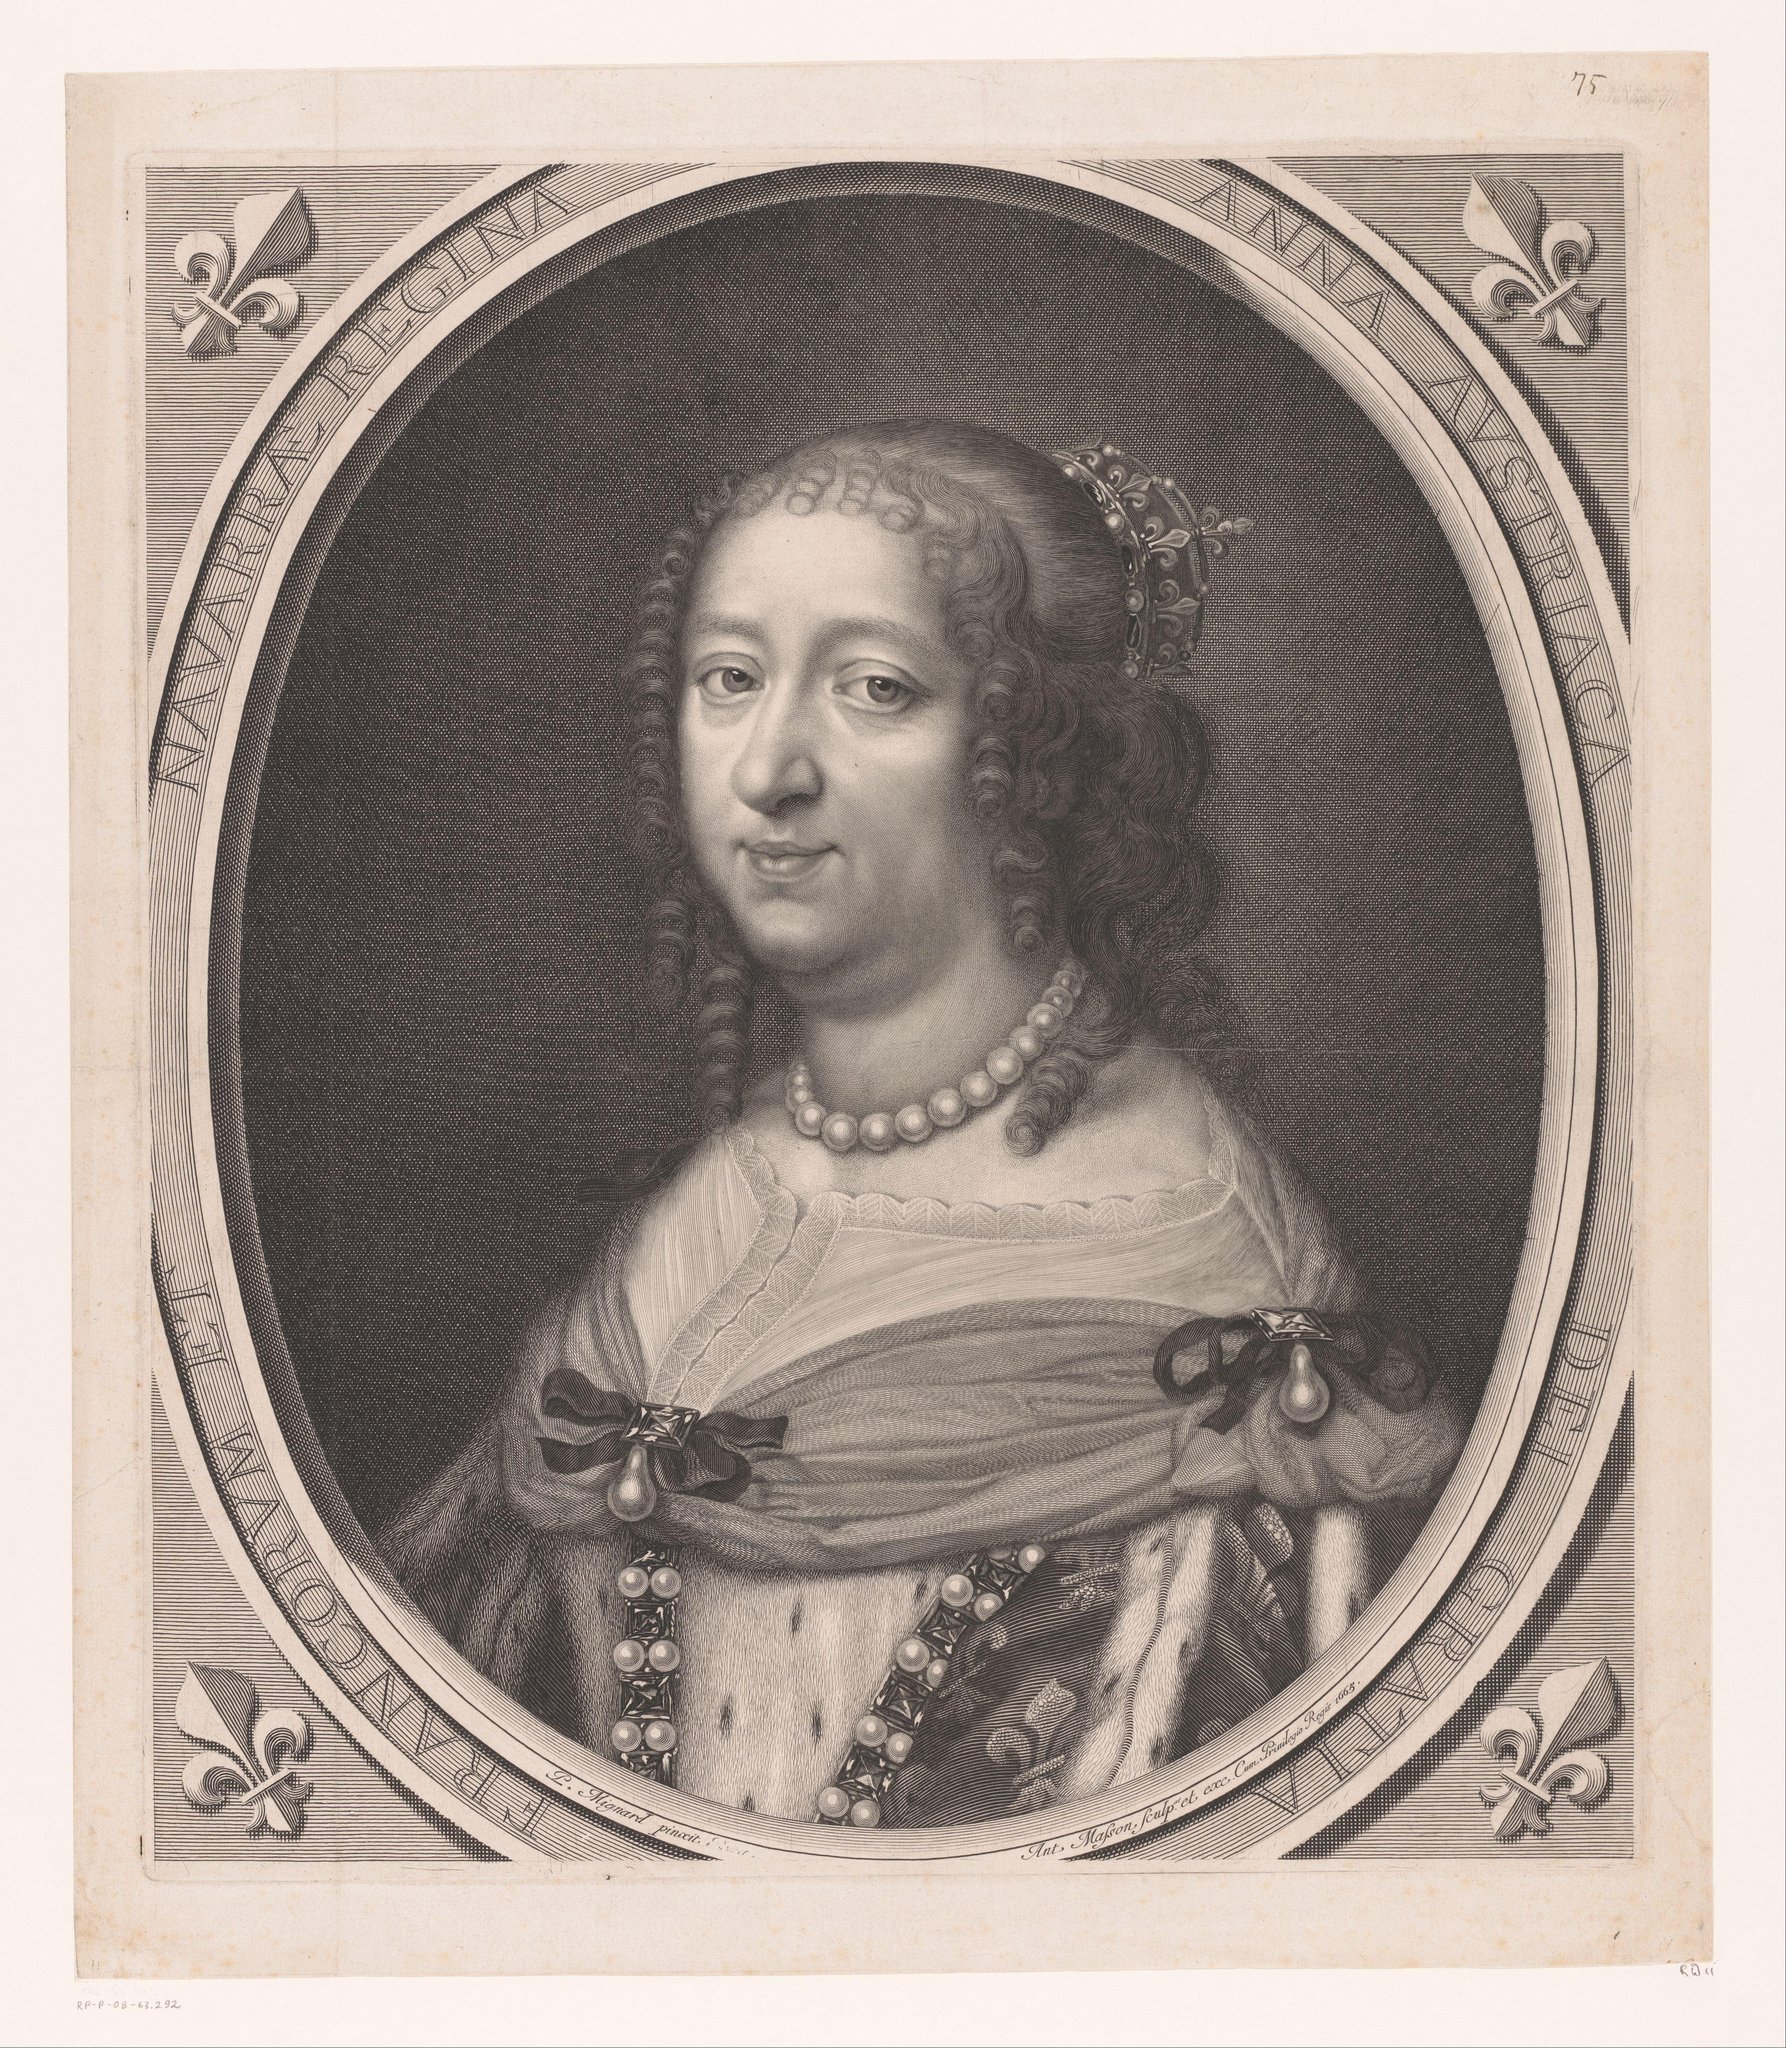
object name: print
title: Portret van Anna van Oostenrijk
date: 1665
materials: paper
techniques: engraving, etching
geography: paris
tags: anna van oostenrijk (koningin van frankrijk), historical persons - bb - woman, queen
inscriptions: number: ‘75’, collector's mark: Lugt 789a, collector's mark: Lugt 240